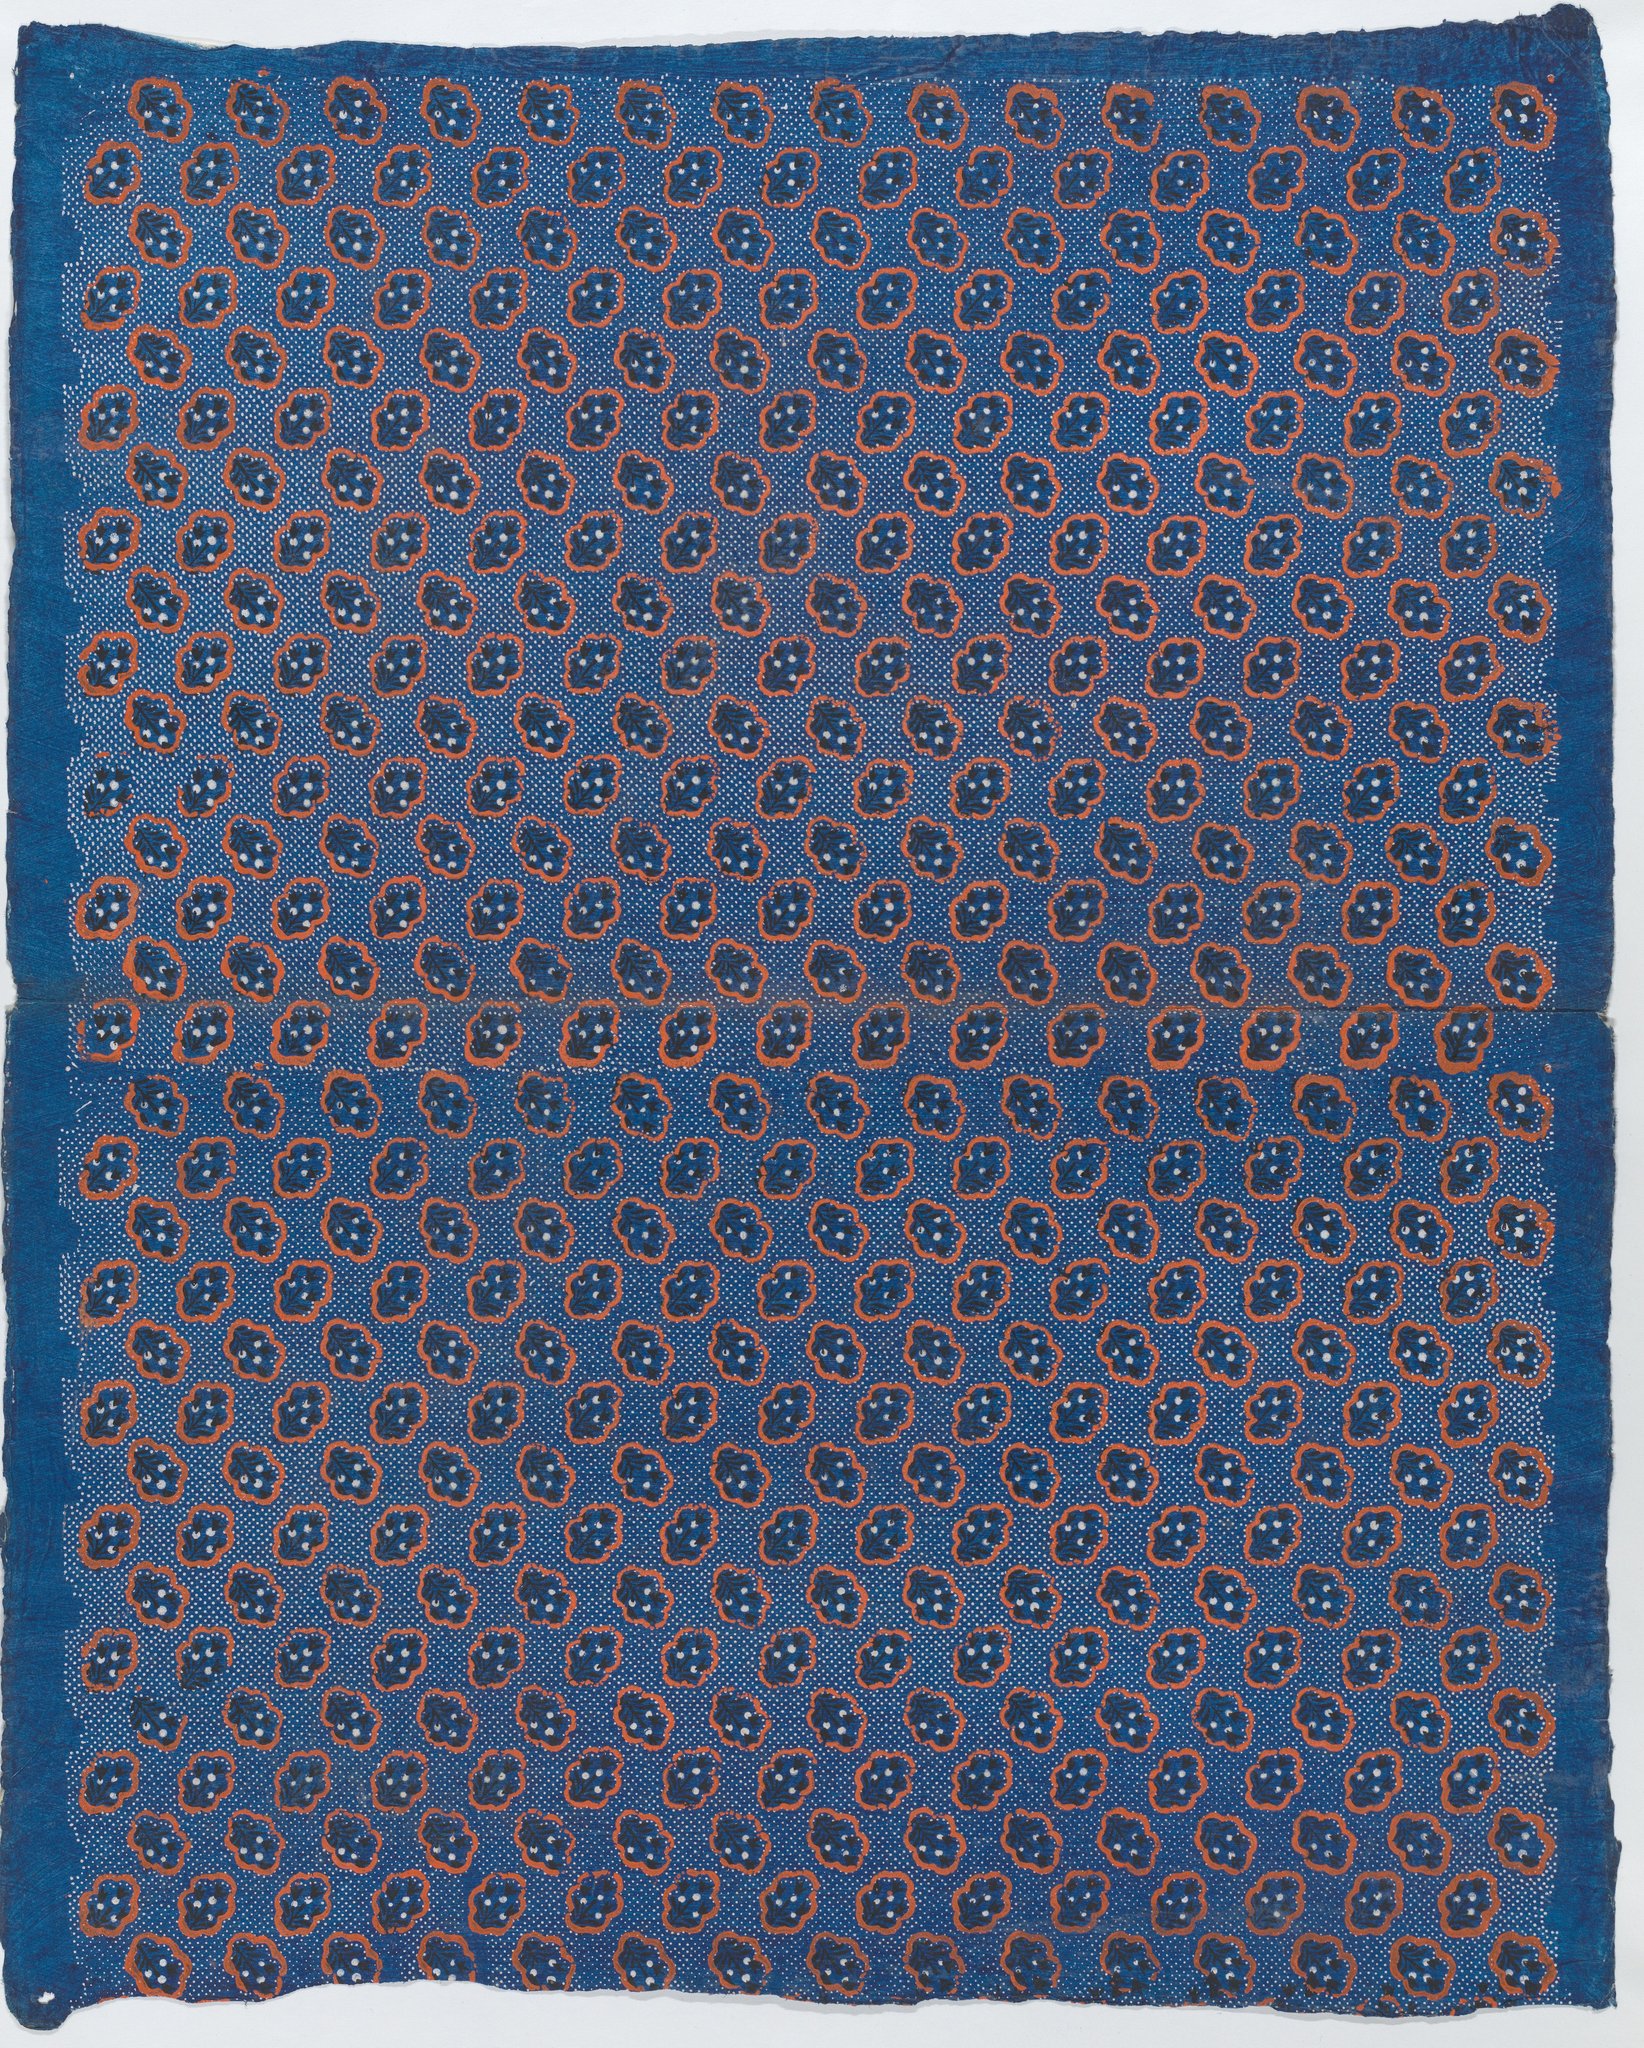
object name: print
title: Blue sheet with two borders with a white floral and lace pattern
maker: Anonymous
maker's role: artist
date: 1767-1866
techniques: relief print